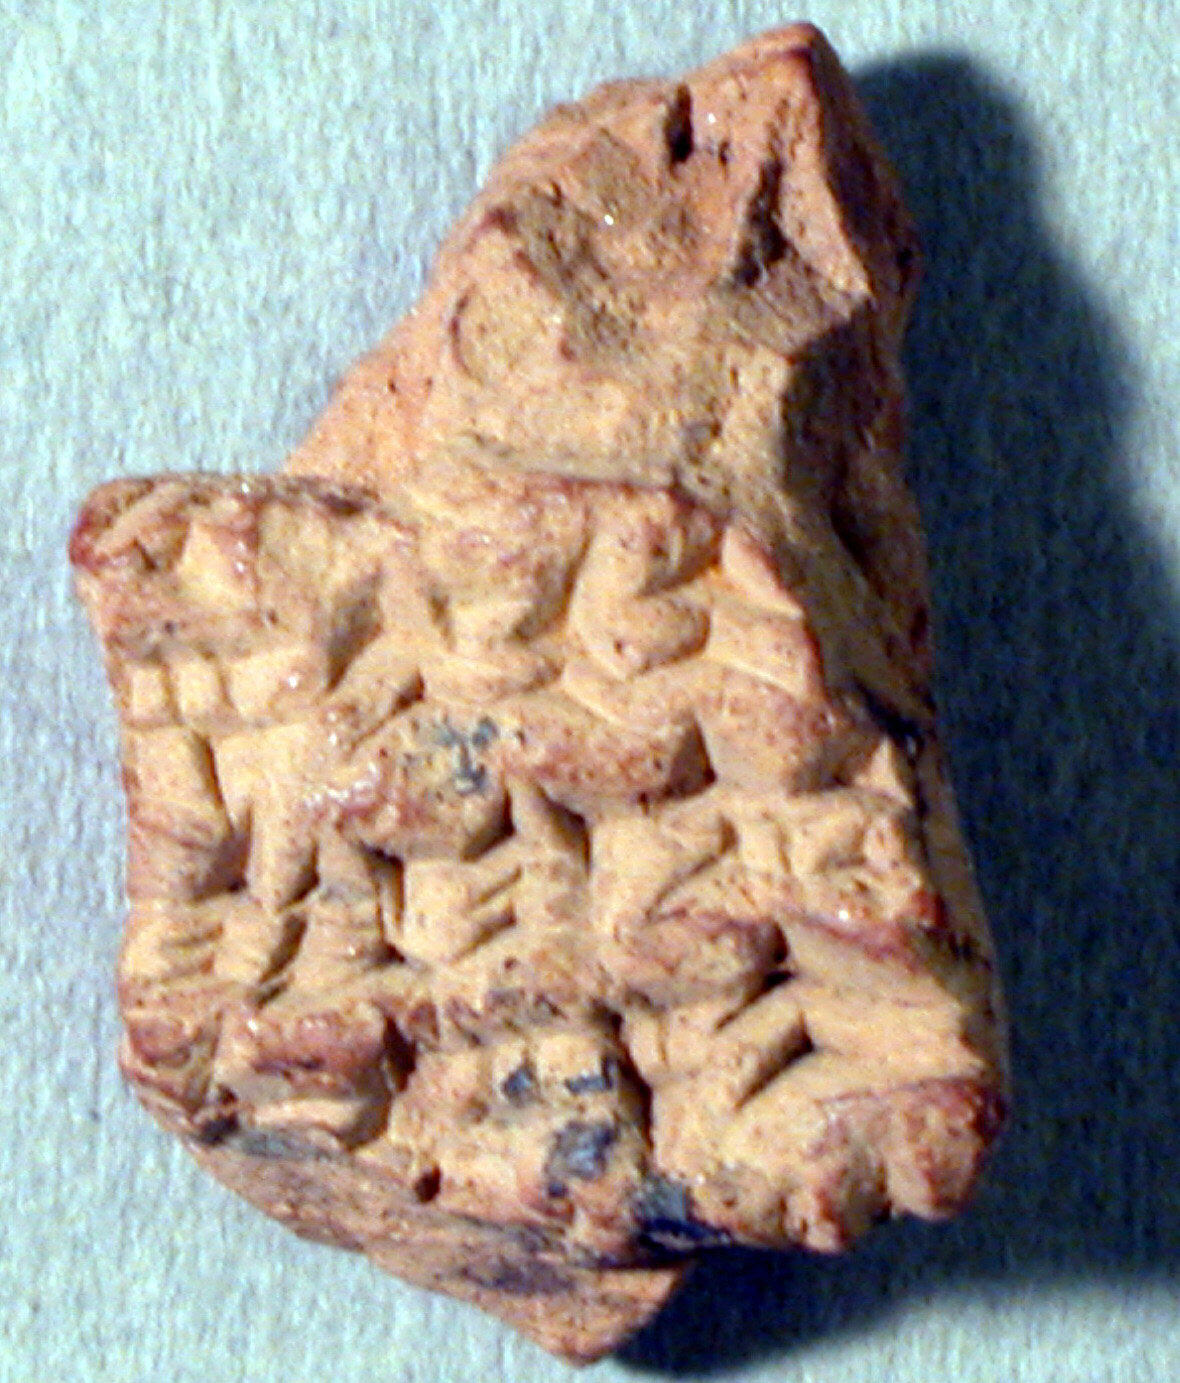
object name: cuneiform tablet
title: Cuneiform tablet: fragment, Ebabbar archive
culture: achaemenid or babylonian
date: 700-301 BCE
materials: clay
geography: mesopotamia